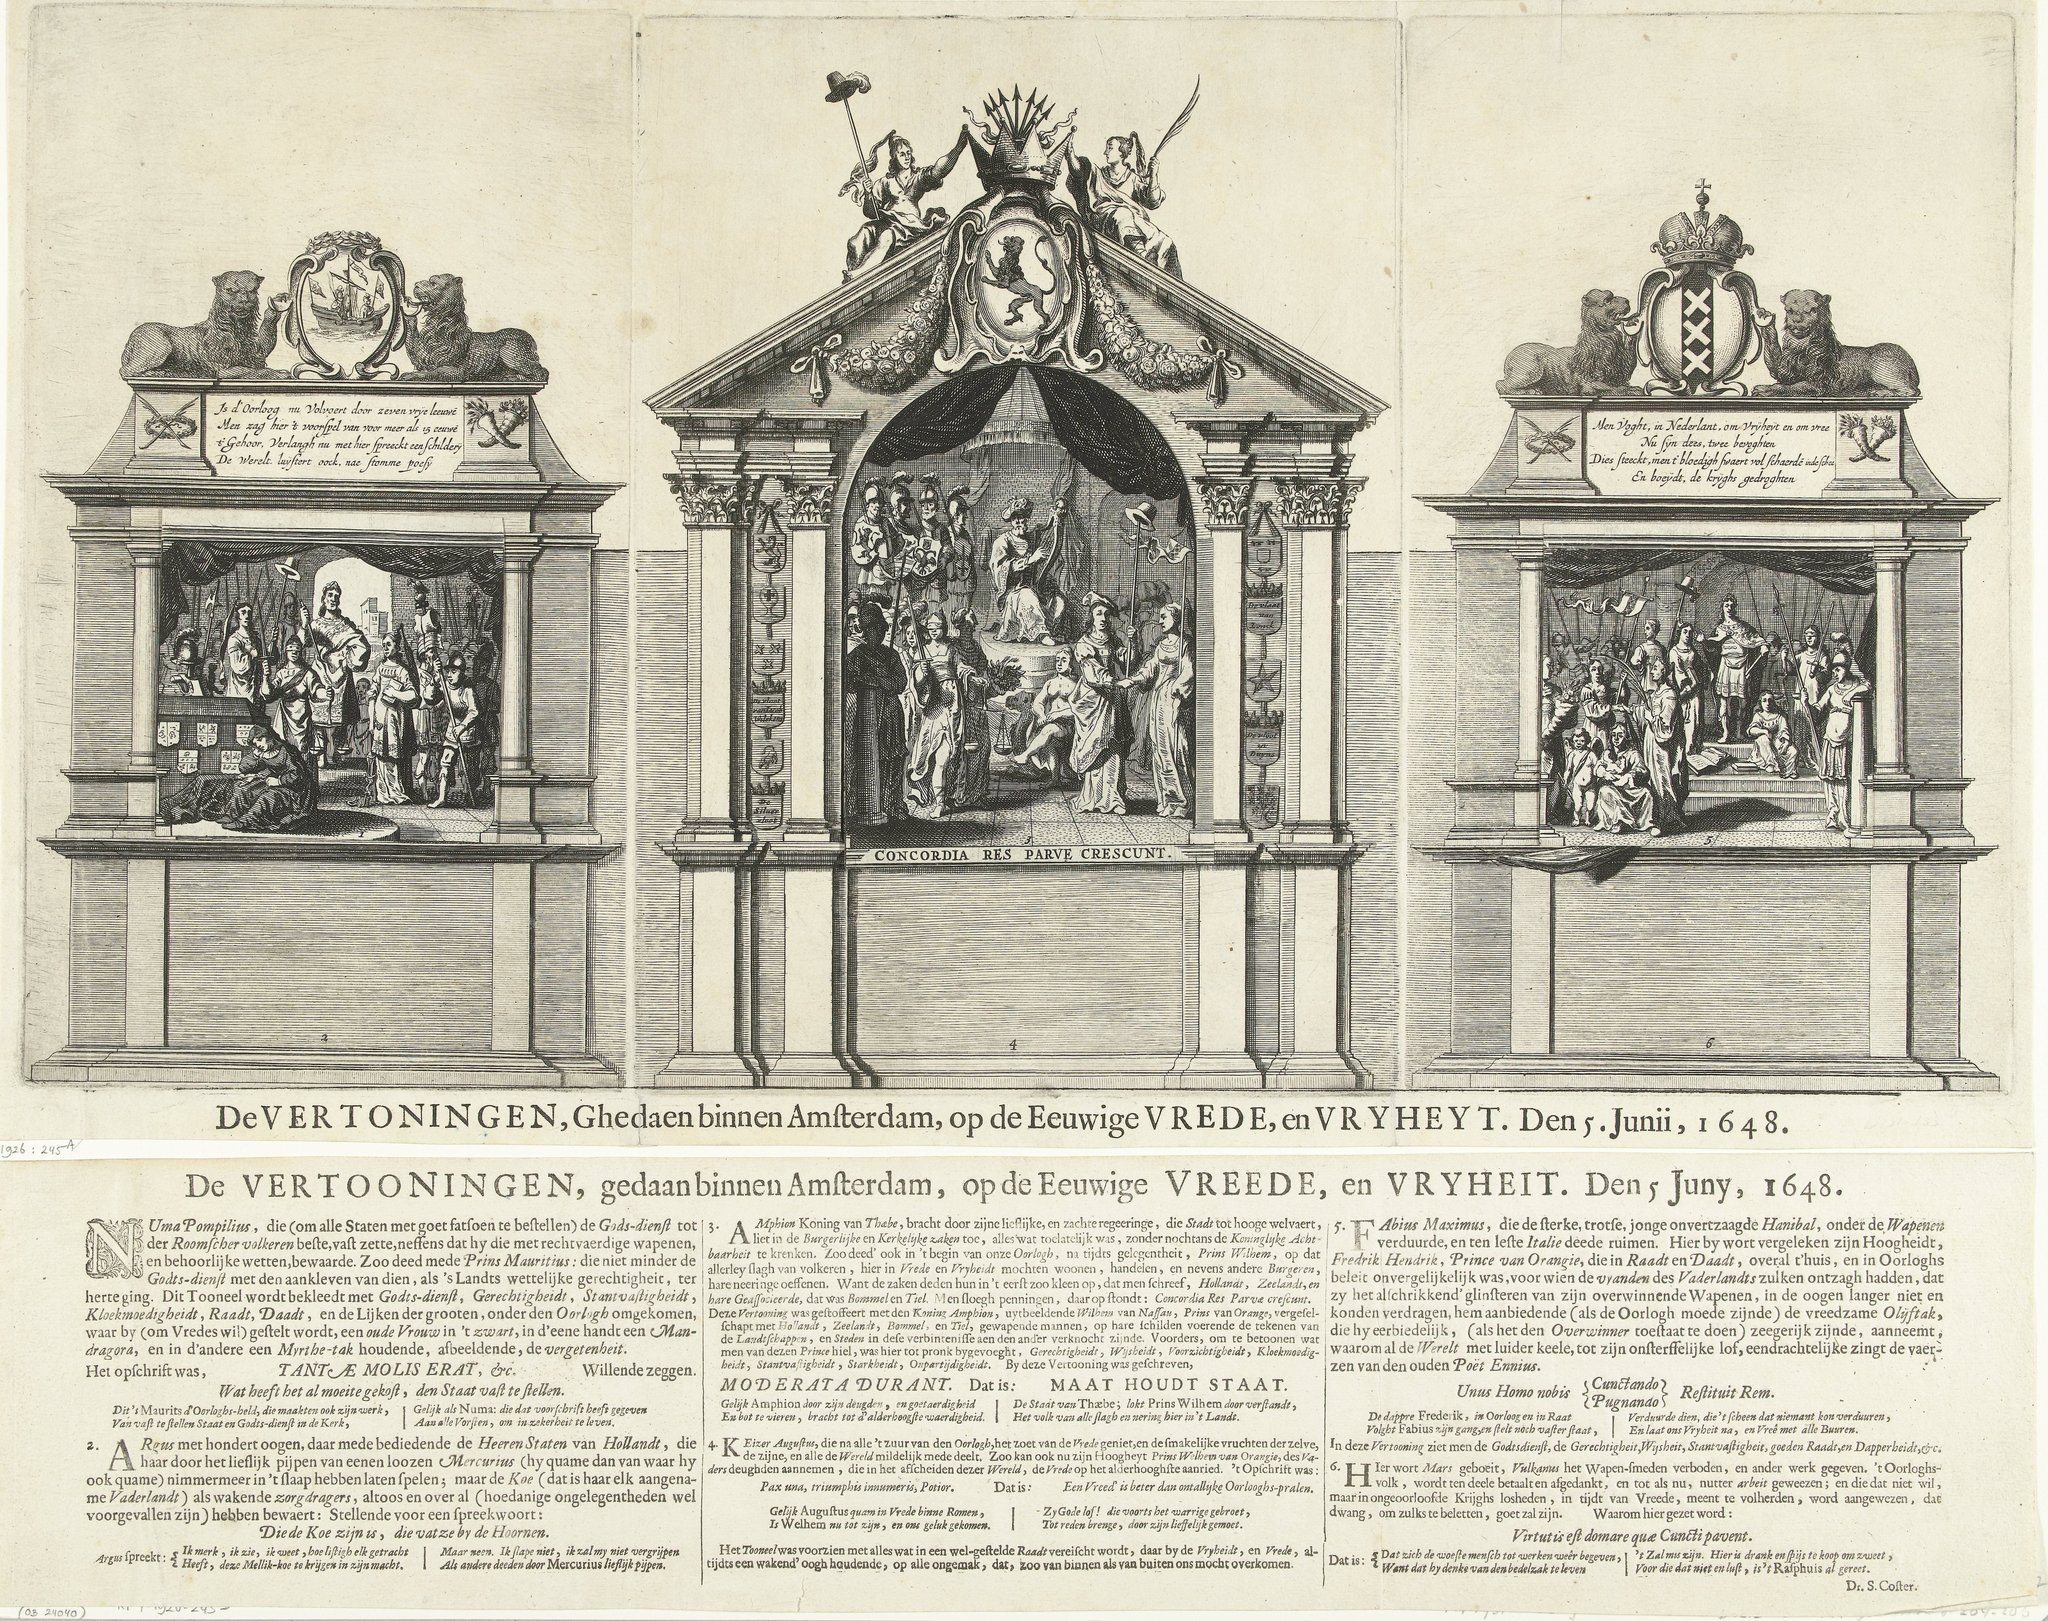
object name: print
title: De Vertooningen, gedaan binnen Amsterdam, op de Eeuwige Vreede, en Vryheit. Den 5. Juny, 1648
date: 1648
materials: paper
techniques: letterpress printing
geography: northern netherlands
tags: dam, viering van de vrede van munster te amsterdam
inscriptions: collector's mark: Lugt 2228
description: Tekstblad bij de prent van het toneel met drie van de zes zinnebeeldige vertoningen die op de Dam zijn opgevoerd ter ere van de Vrede van Munster op 5 juni 1648. Gedrukte tekst in drie kolommen.